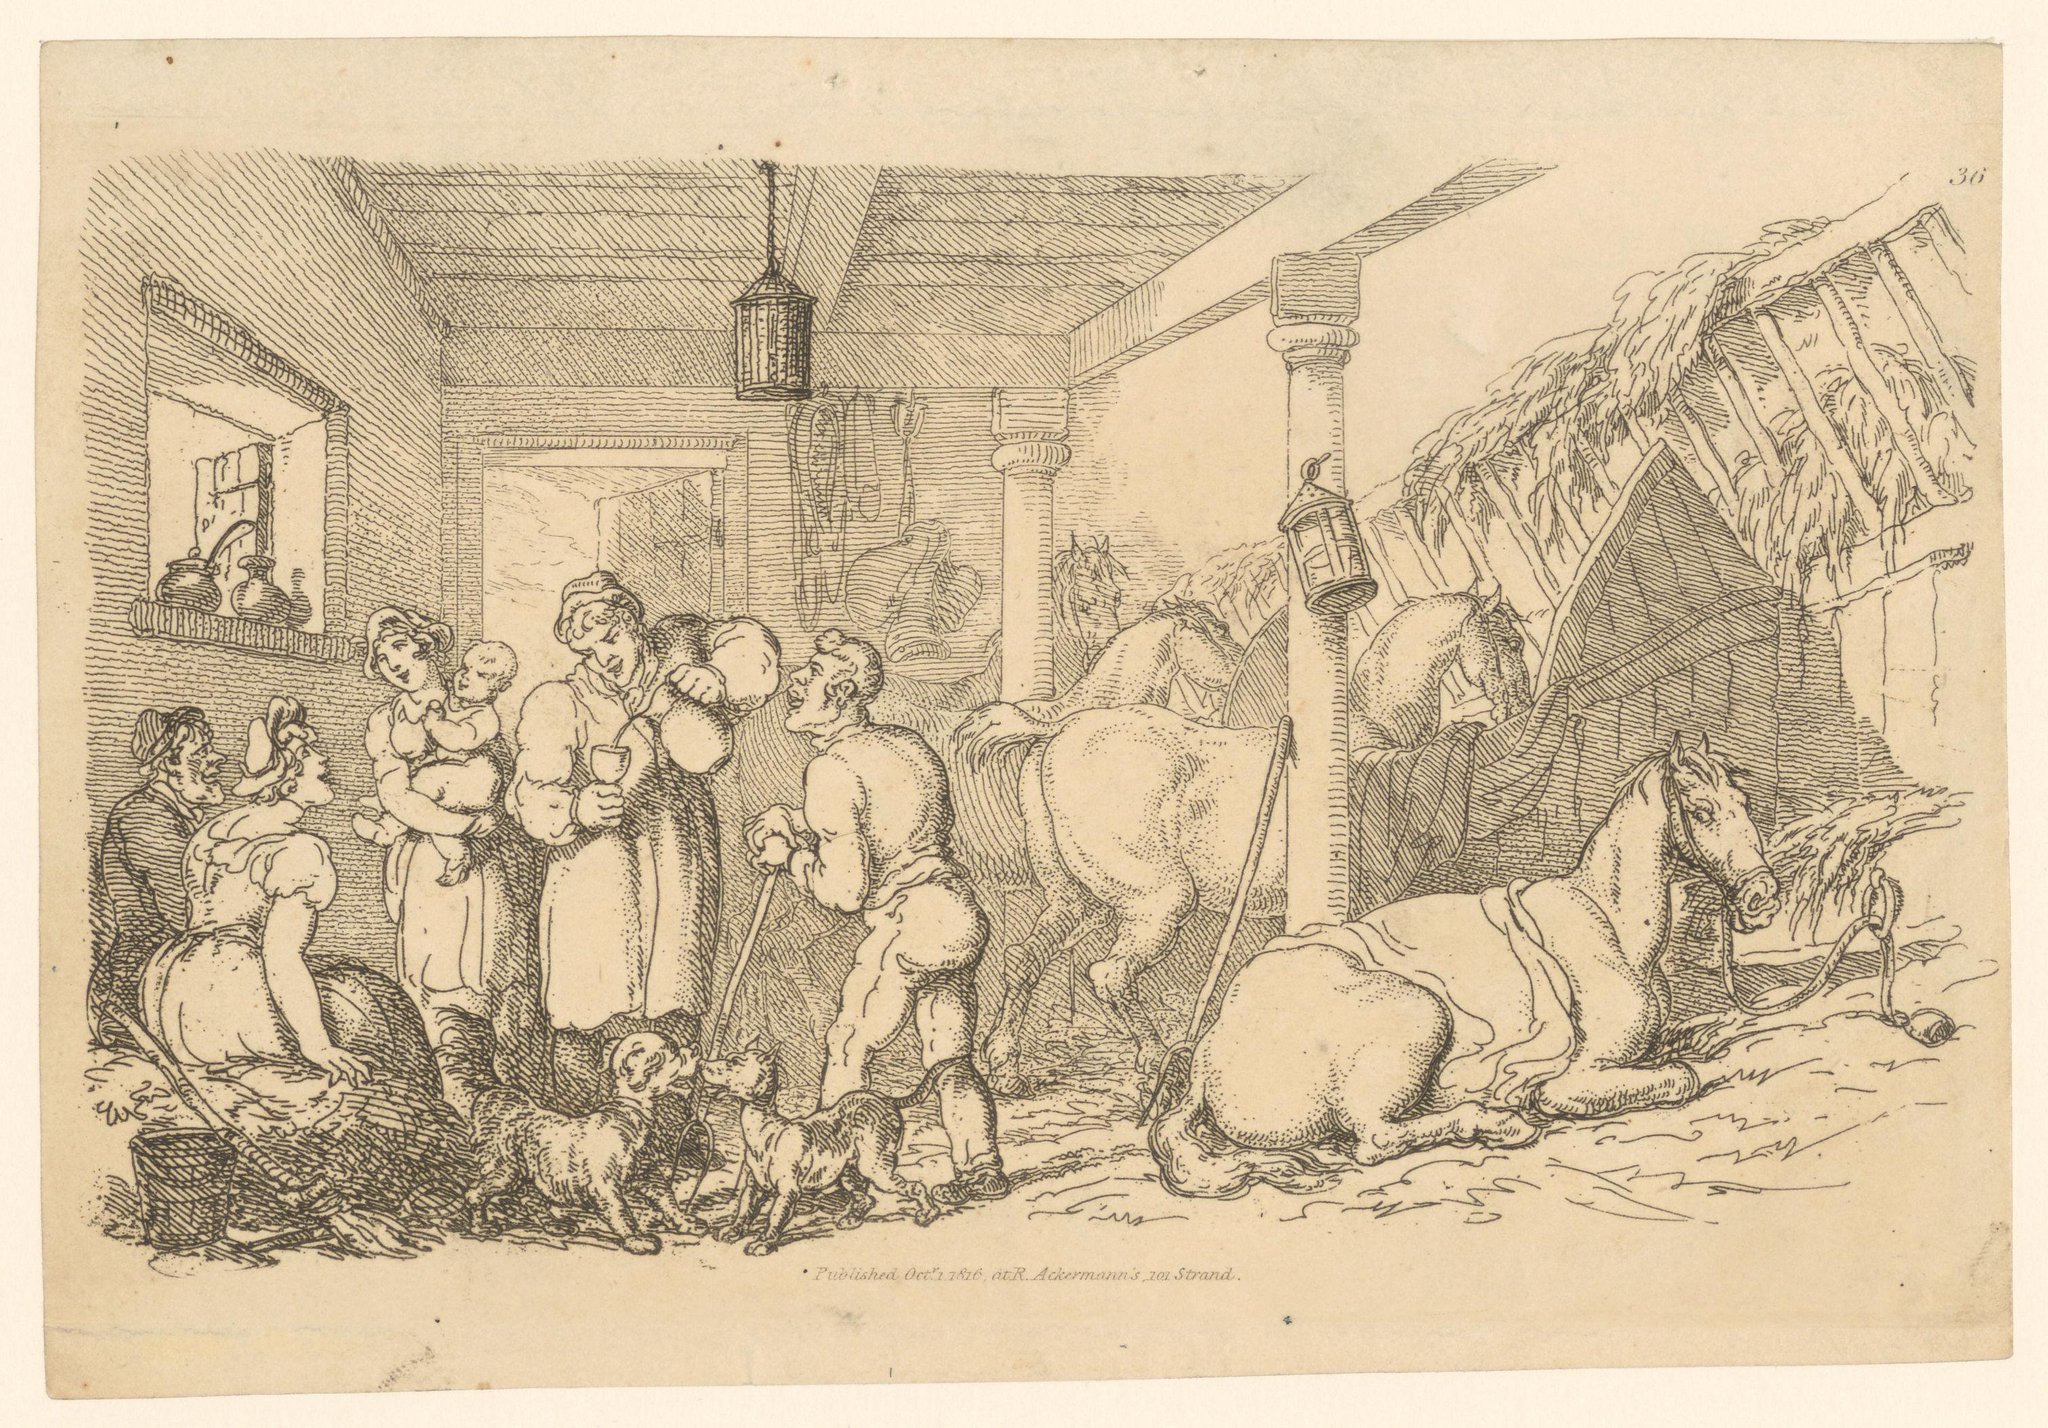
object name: print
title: Familie in een paardenstal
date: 1816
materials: paper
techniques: etching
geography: london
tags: family life, stall, stable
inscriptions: collector's mark: Lugt 2760, collector's mark: Lugt 2228